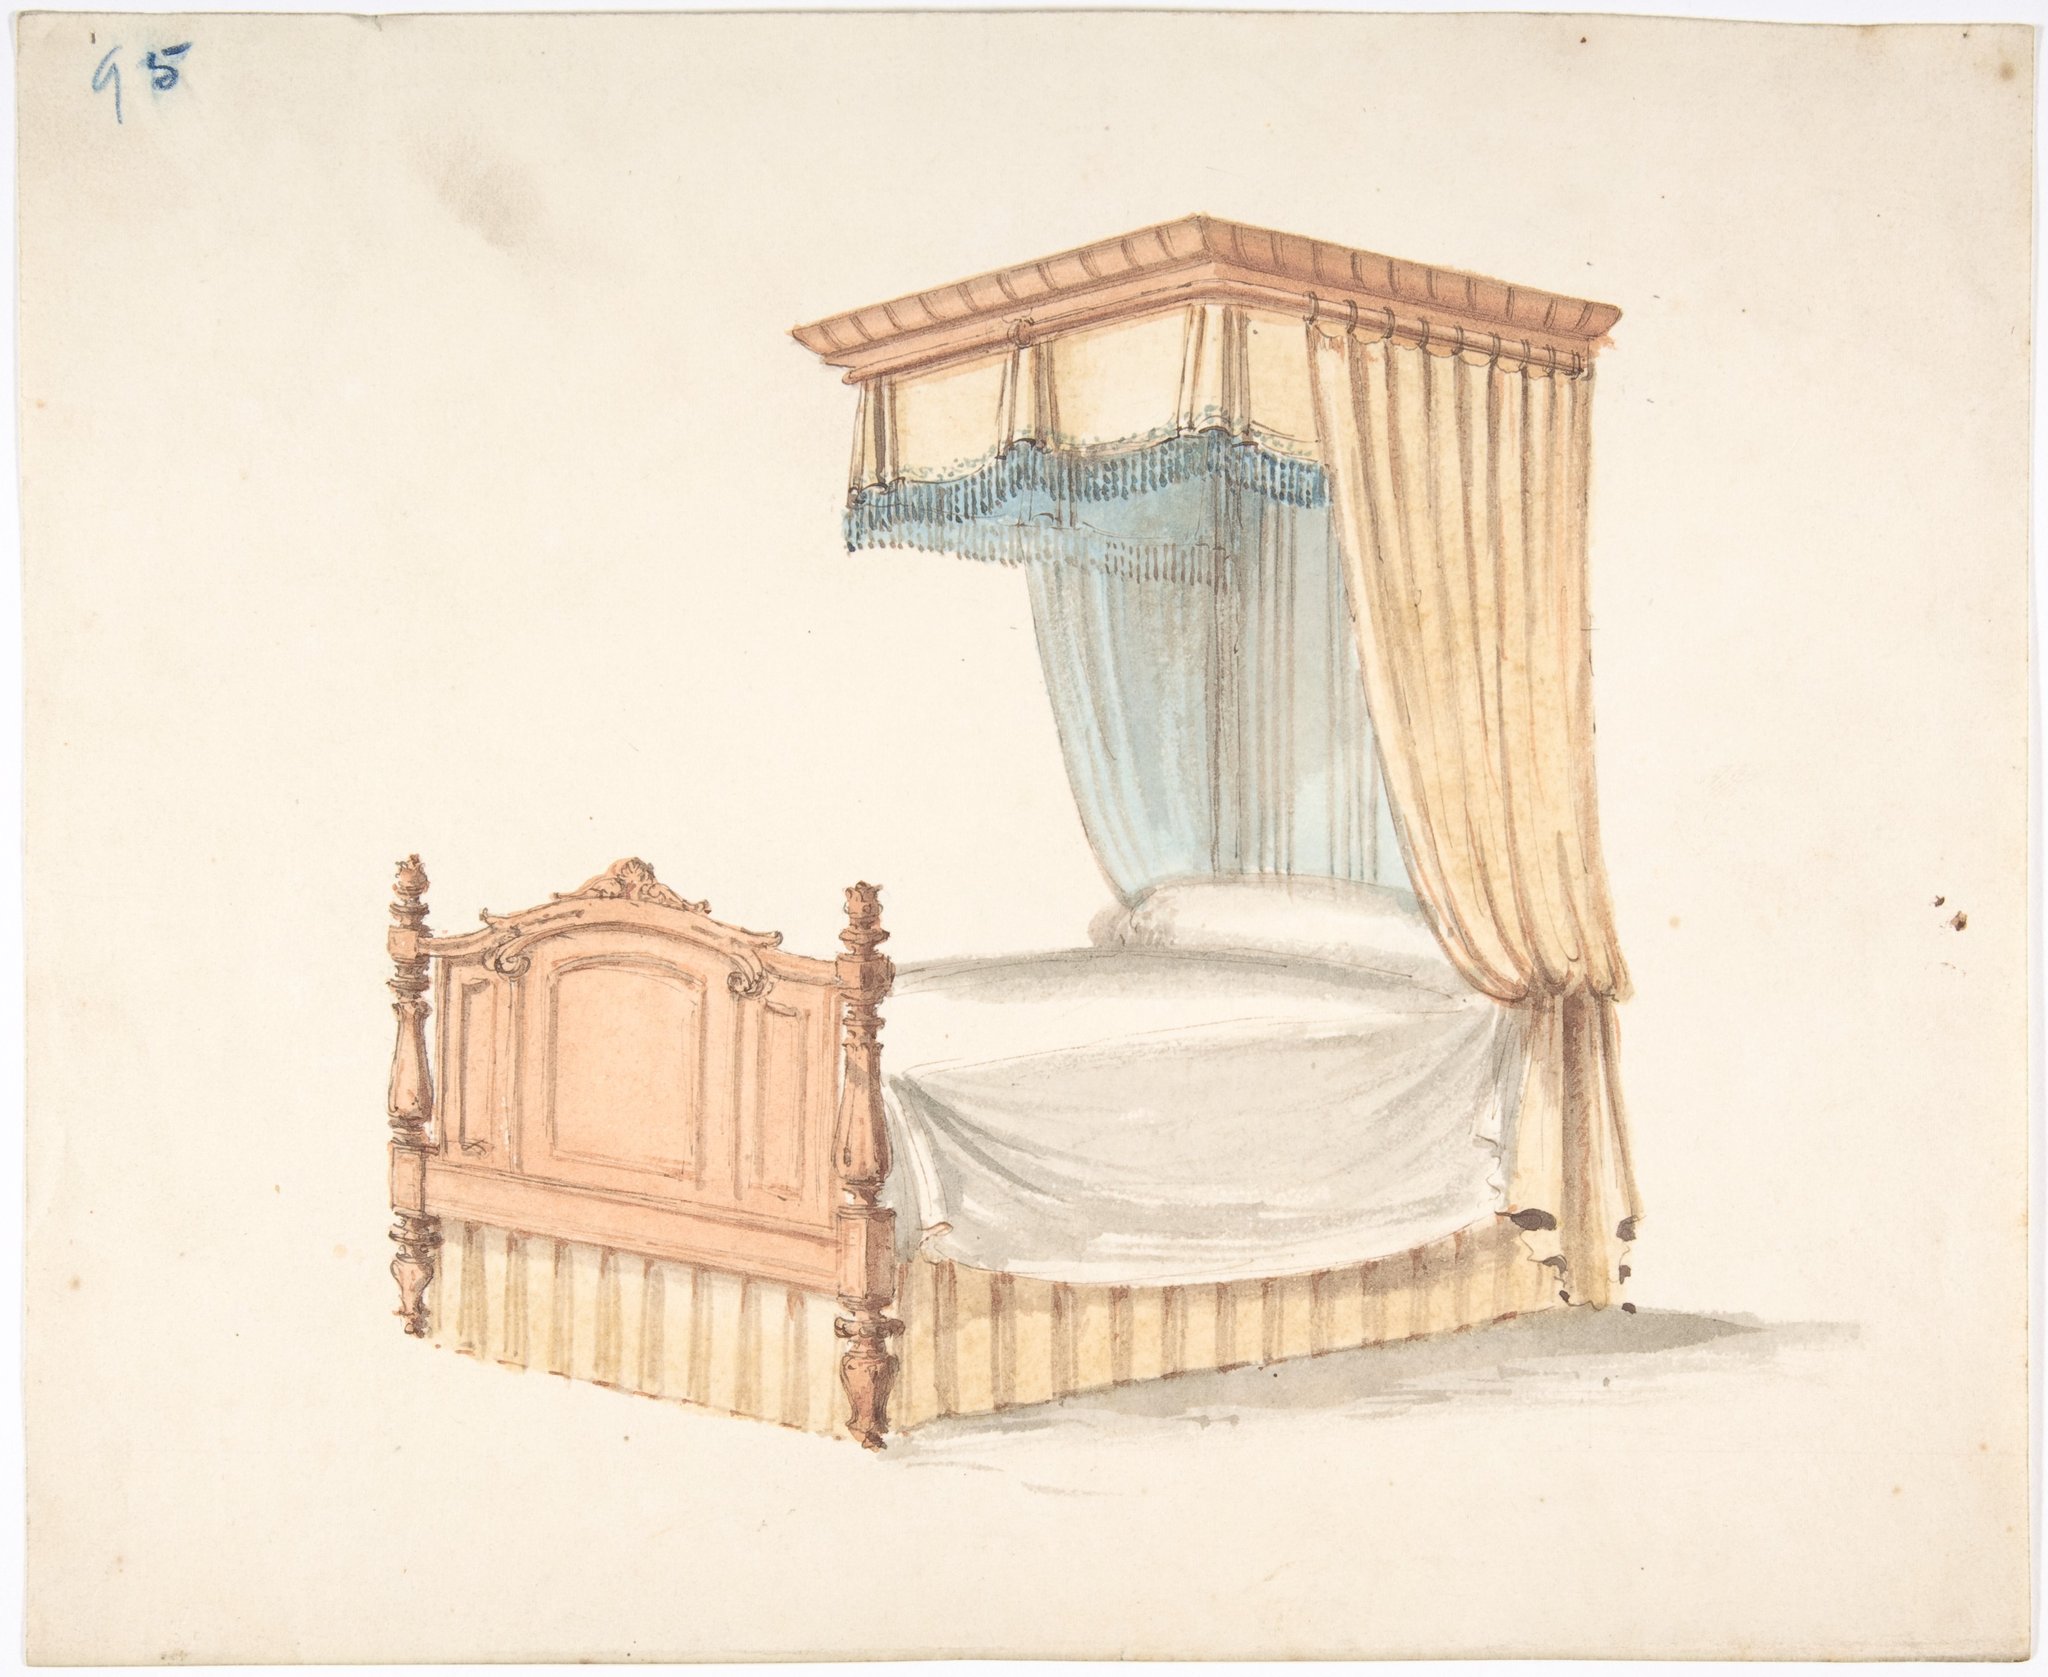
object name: drawing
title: Design for a Bed with Yellow and Blue Fringed Hangings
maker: anonymous, british, 19th century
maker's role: artist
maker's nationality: british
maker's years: 1800-1900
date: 1801-1833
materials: ink, watercolor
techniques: brush, pen, wash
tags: beds